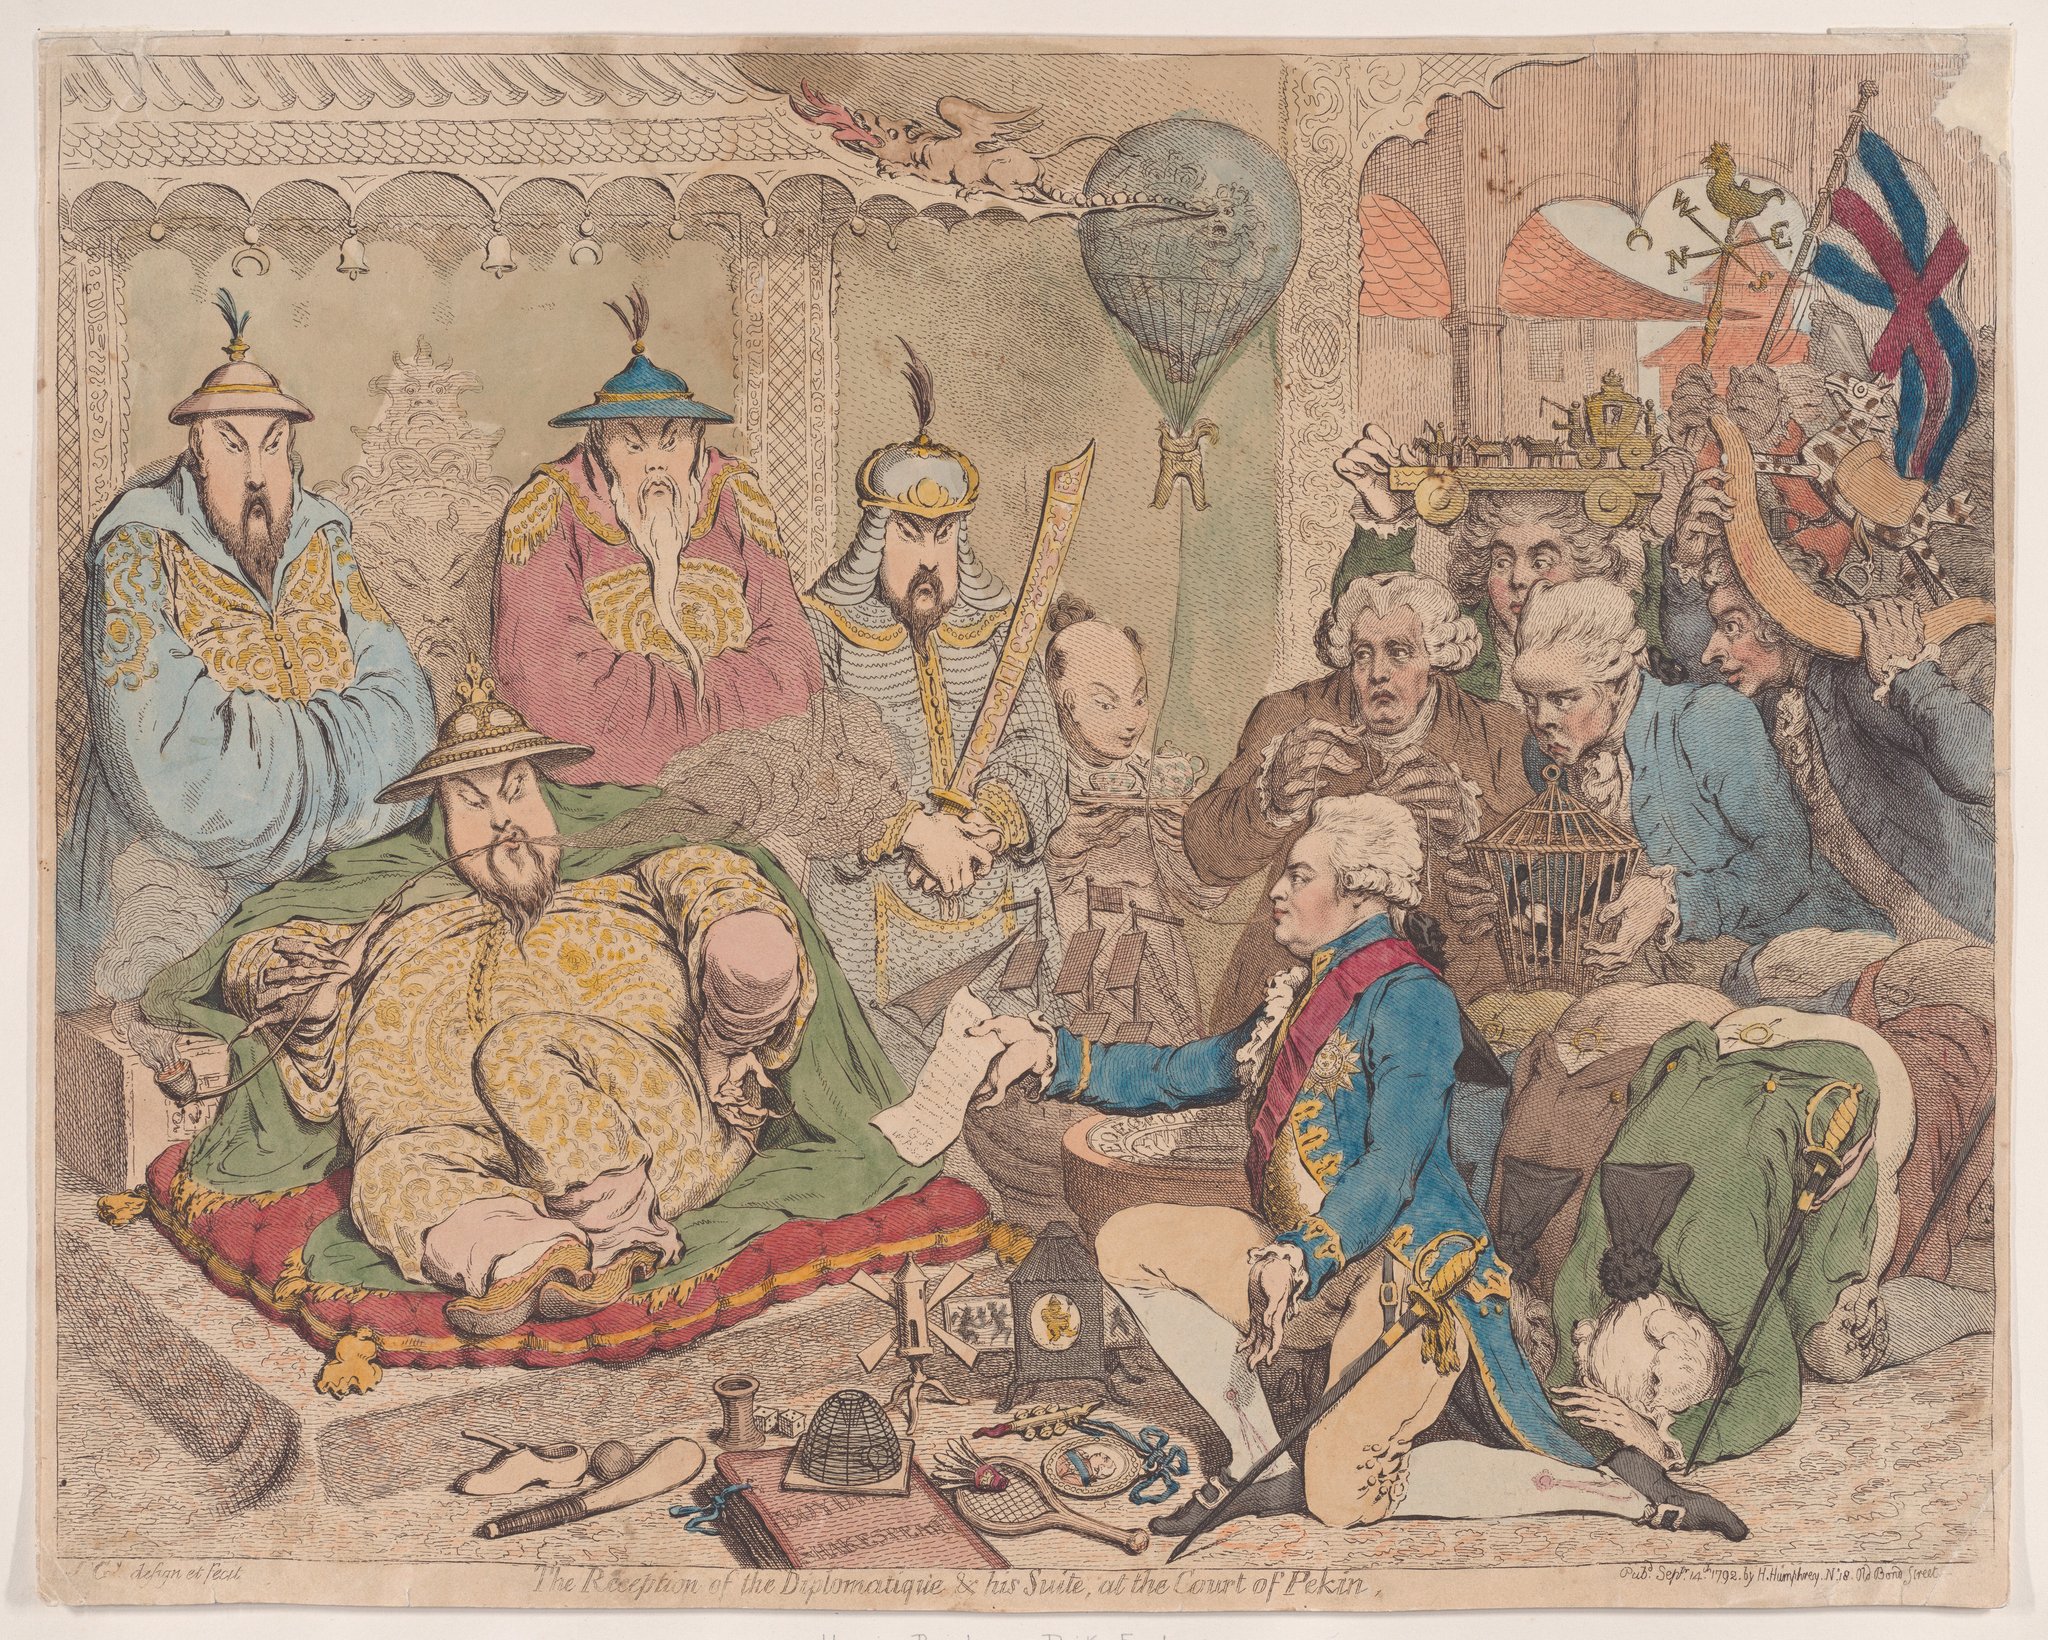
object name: print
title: The Reception of the Diplomatique and his Suite at the Court of Pekin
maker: james gillray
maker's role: artist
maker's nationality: british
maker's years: 1756-1815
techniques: etching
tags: satire,men,politics